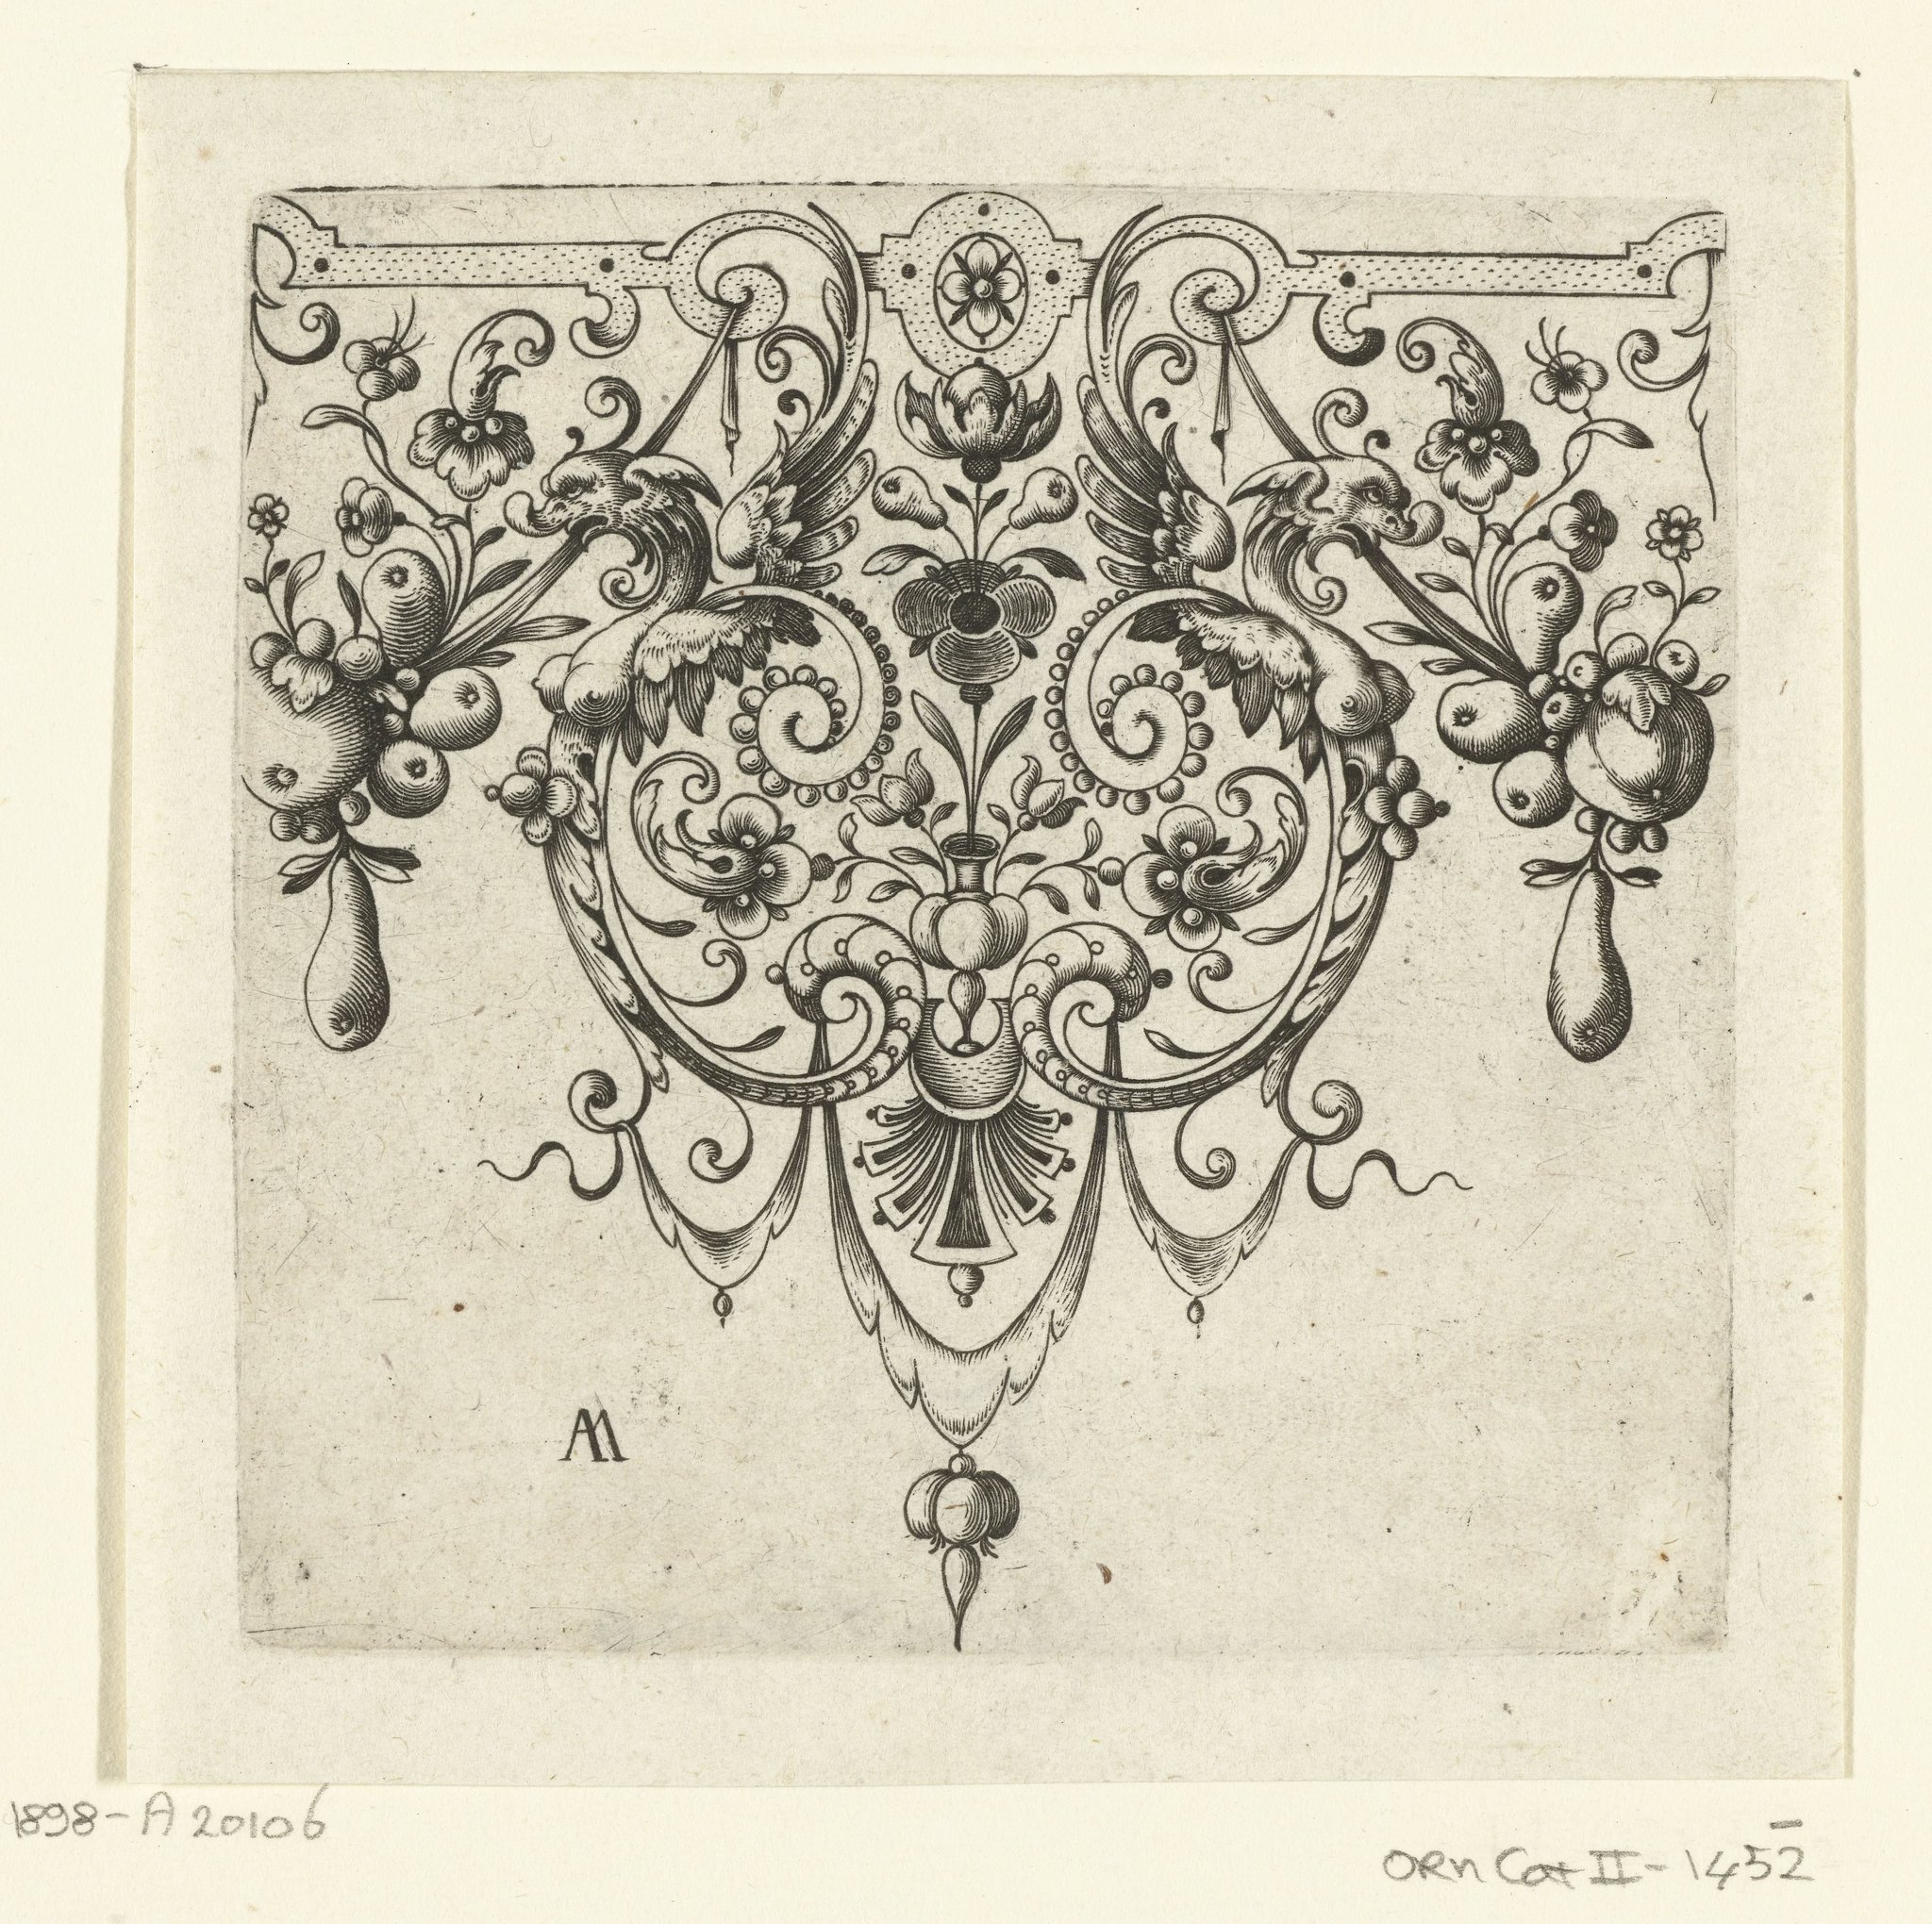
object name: print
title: Spitsen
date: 1675-1700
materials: paper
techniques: engraving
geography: amsterdam